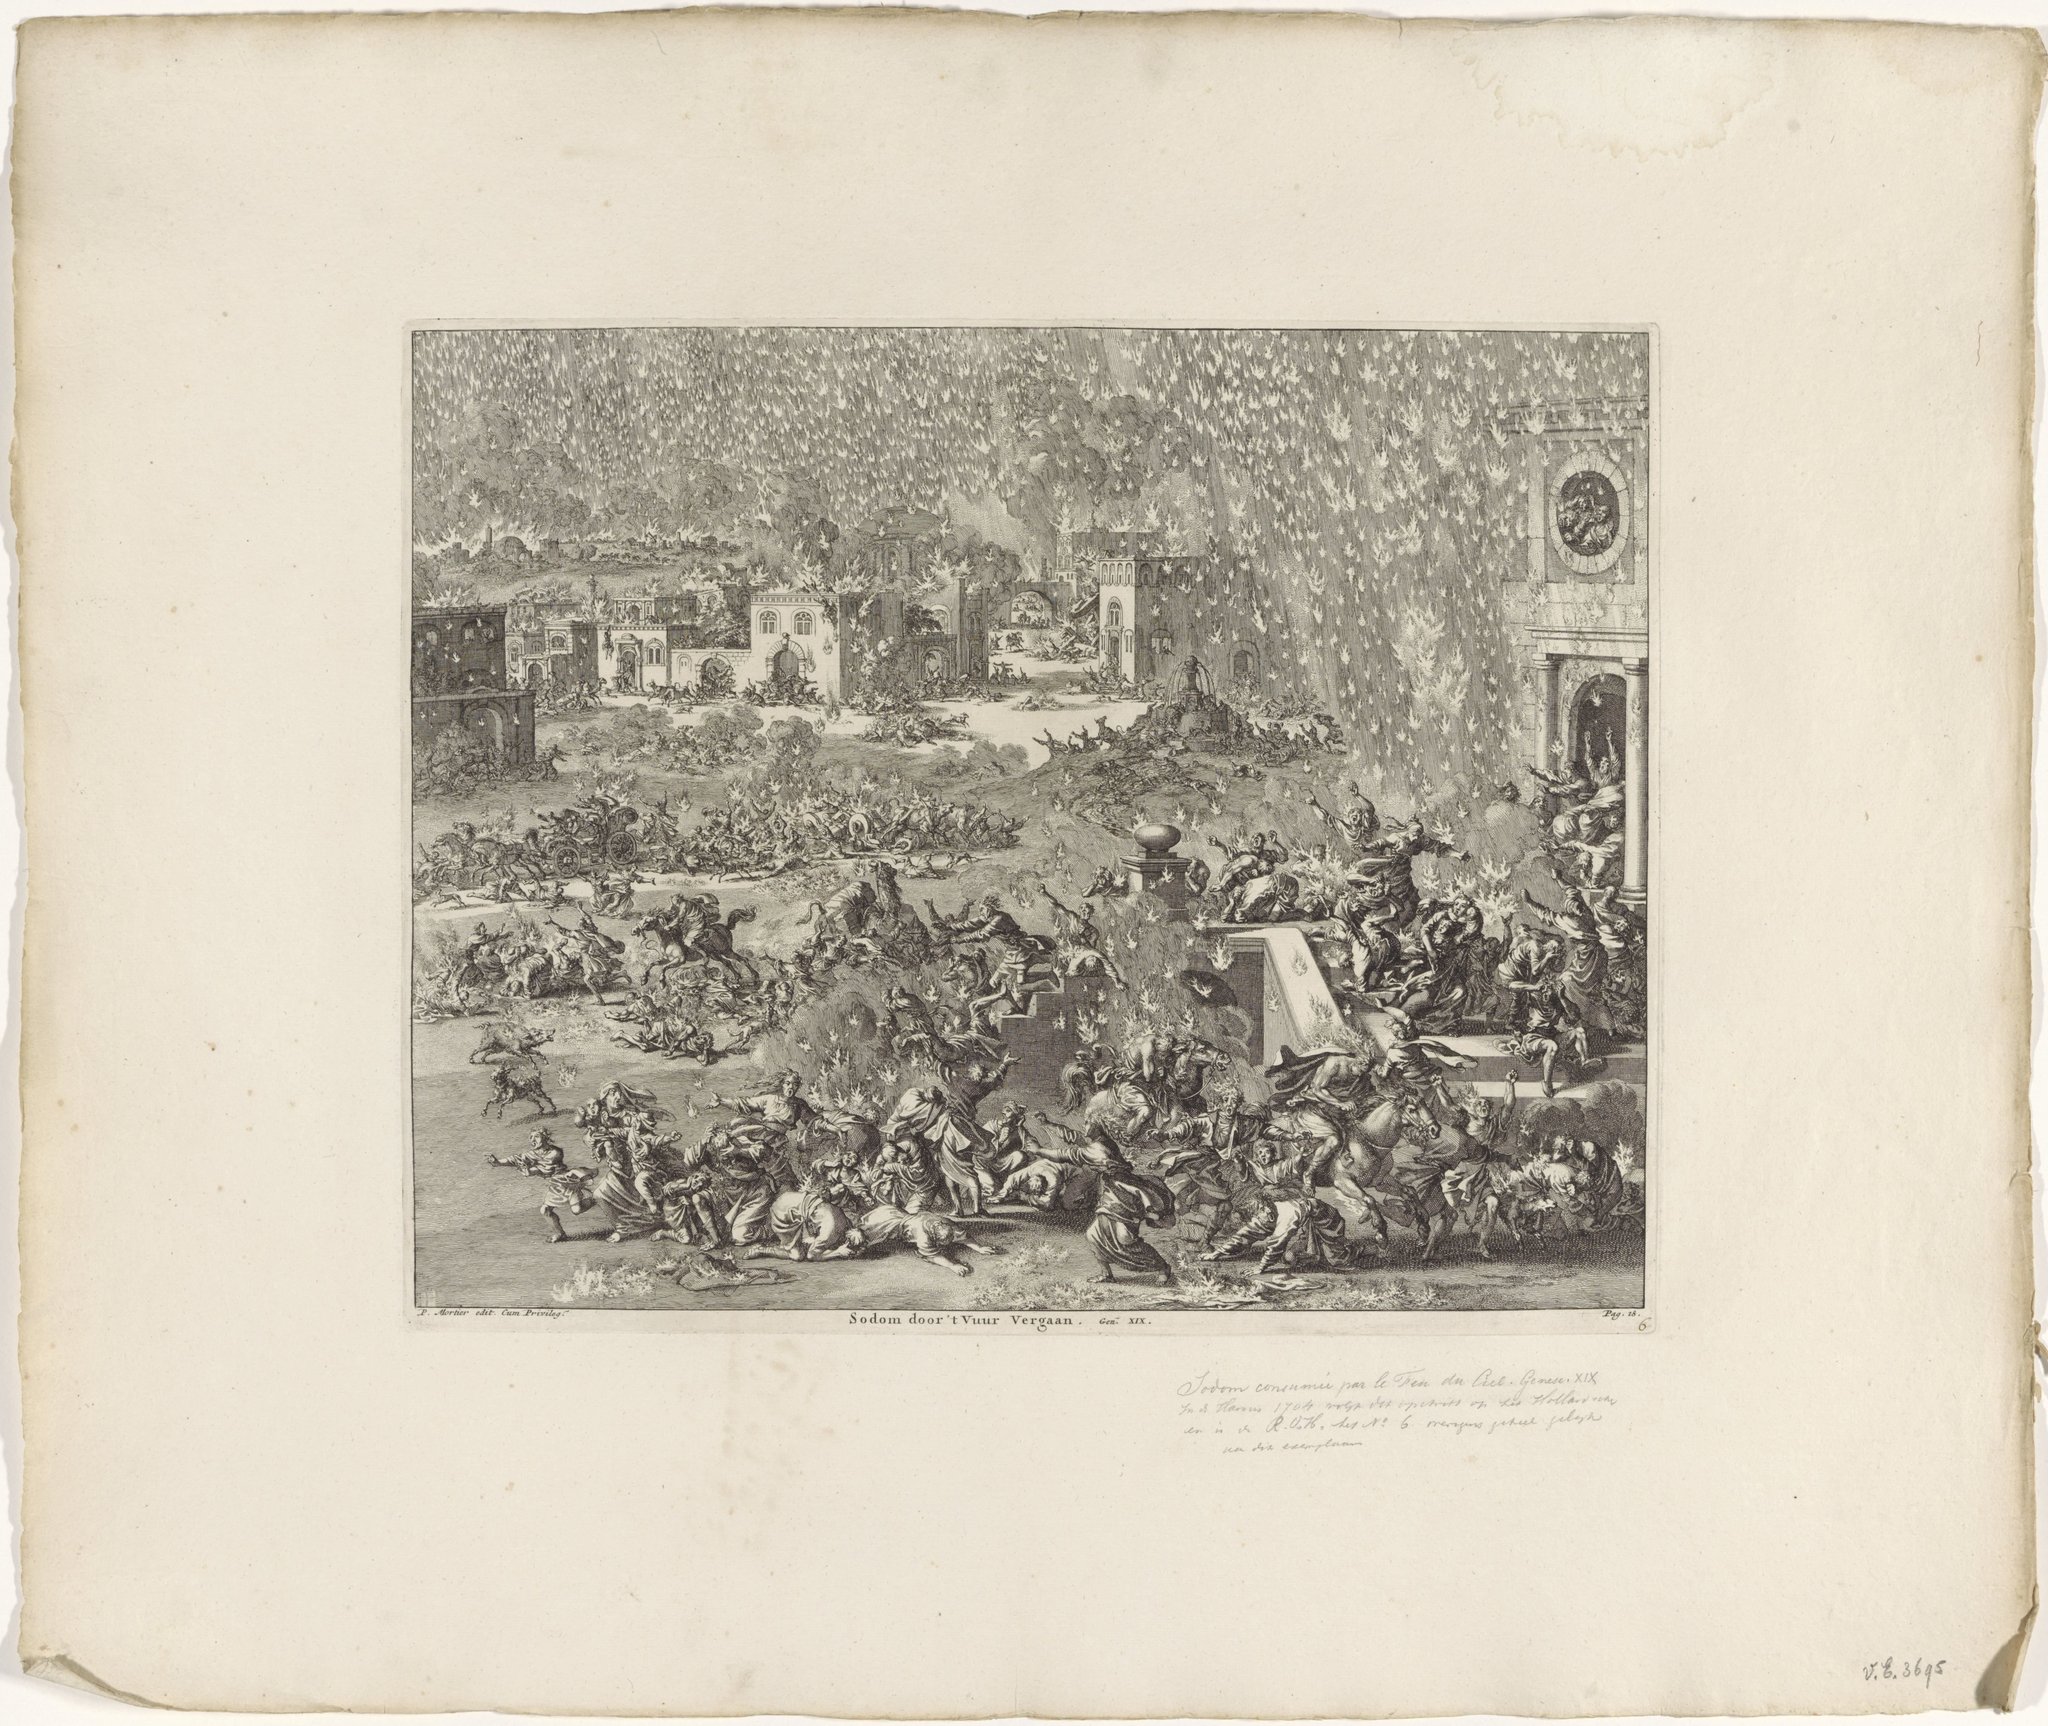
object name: print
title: Sodom door 't Vuur Vergaan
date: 1708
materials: paper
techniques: etching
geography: amsterdam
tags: sodom and gomorrah burning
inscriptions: collector's mark: Lugt 2228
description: Illustratie voor: Icones Biblicae Veteris et Novi Testamenti, Amsterdam: Pieter Mortier, 1708.